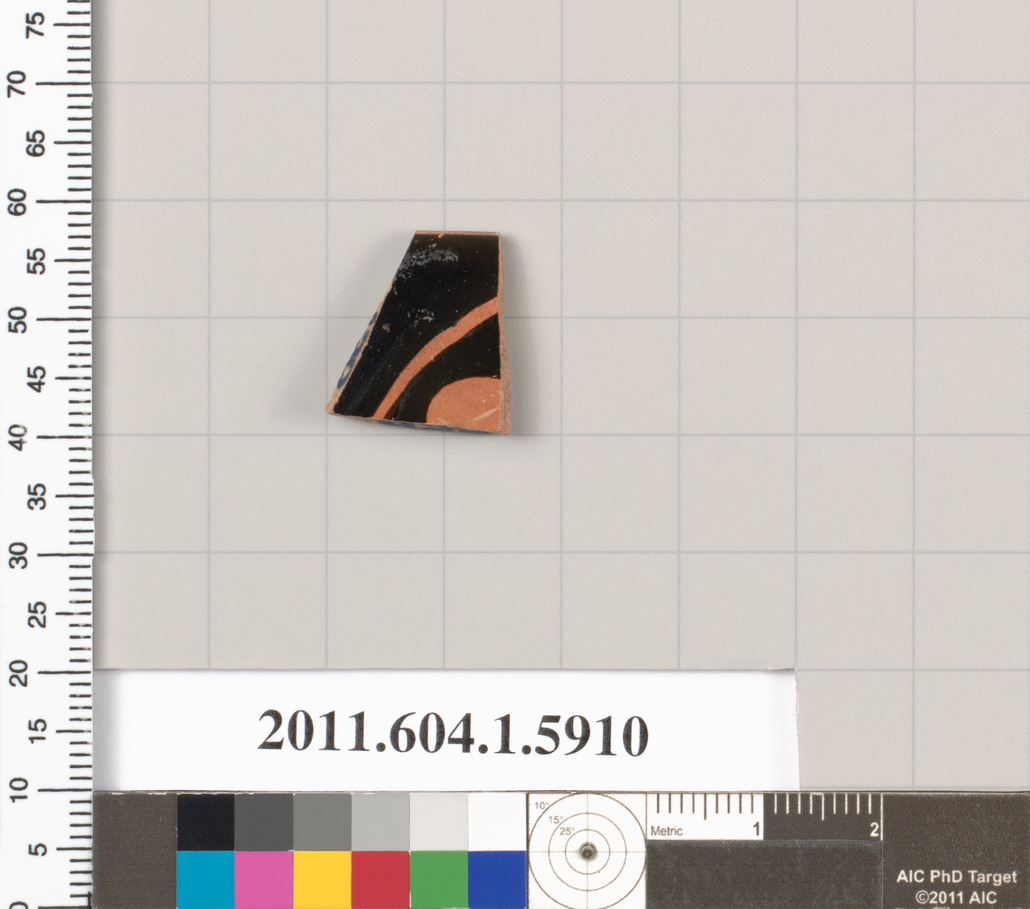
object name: kylix fragment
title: Terracotta rim fragment of a kylix (drinking cup)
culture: greek, attic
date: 520-510 BCE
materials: terracotta